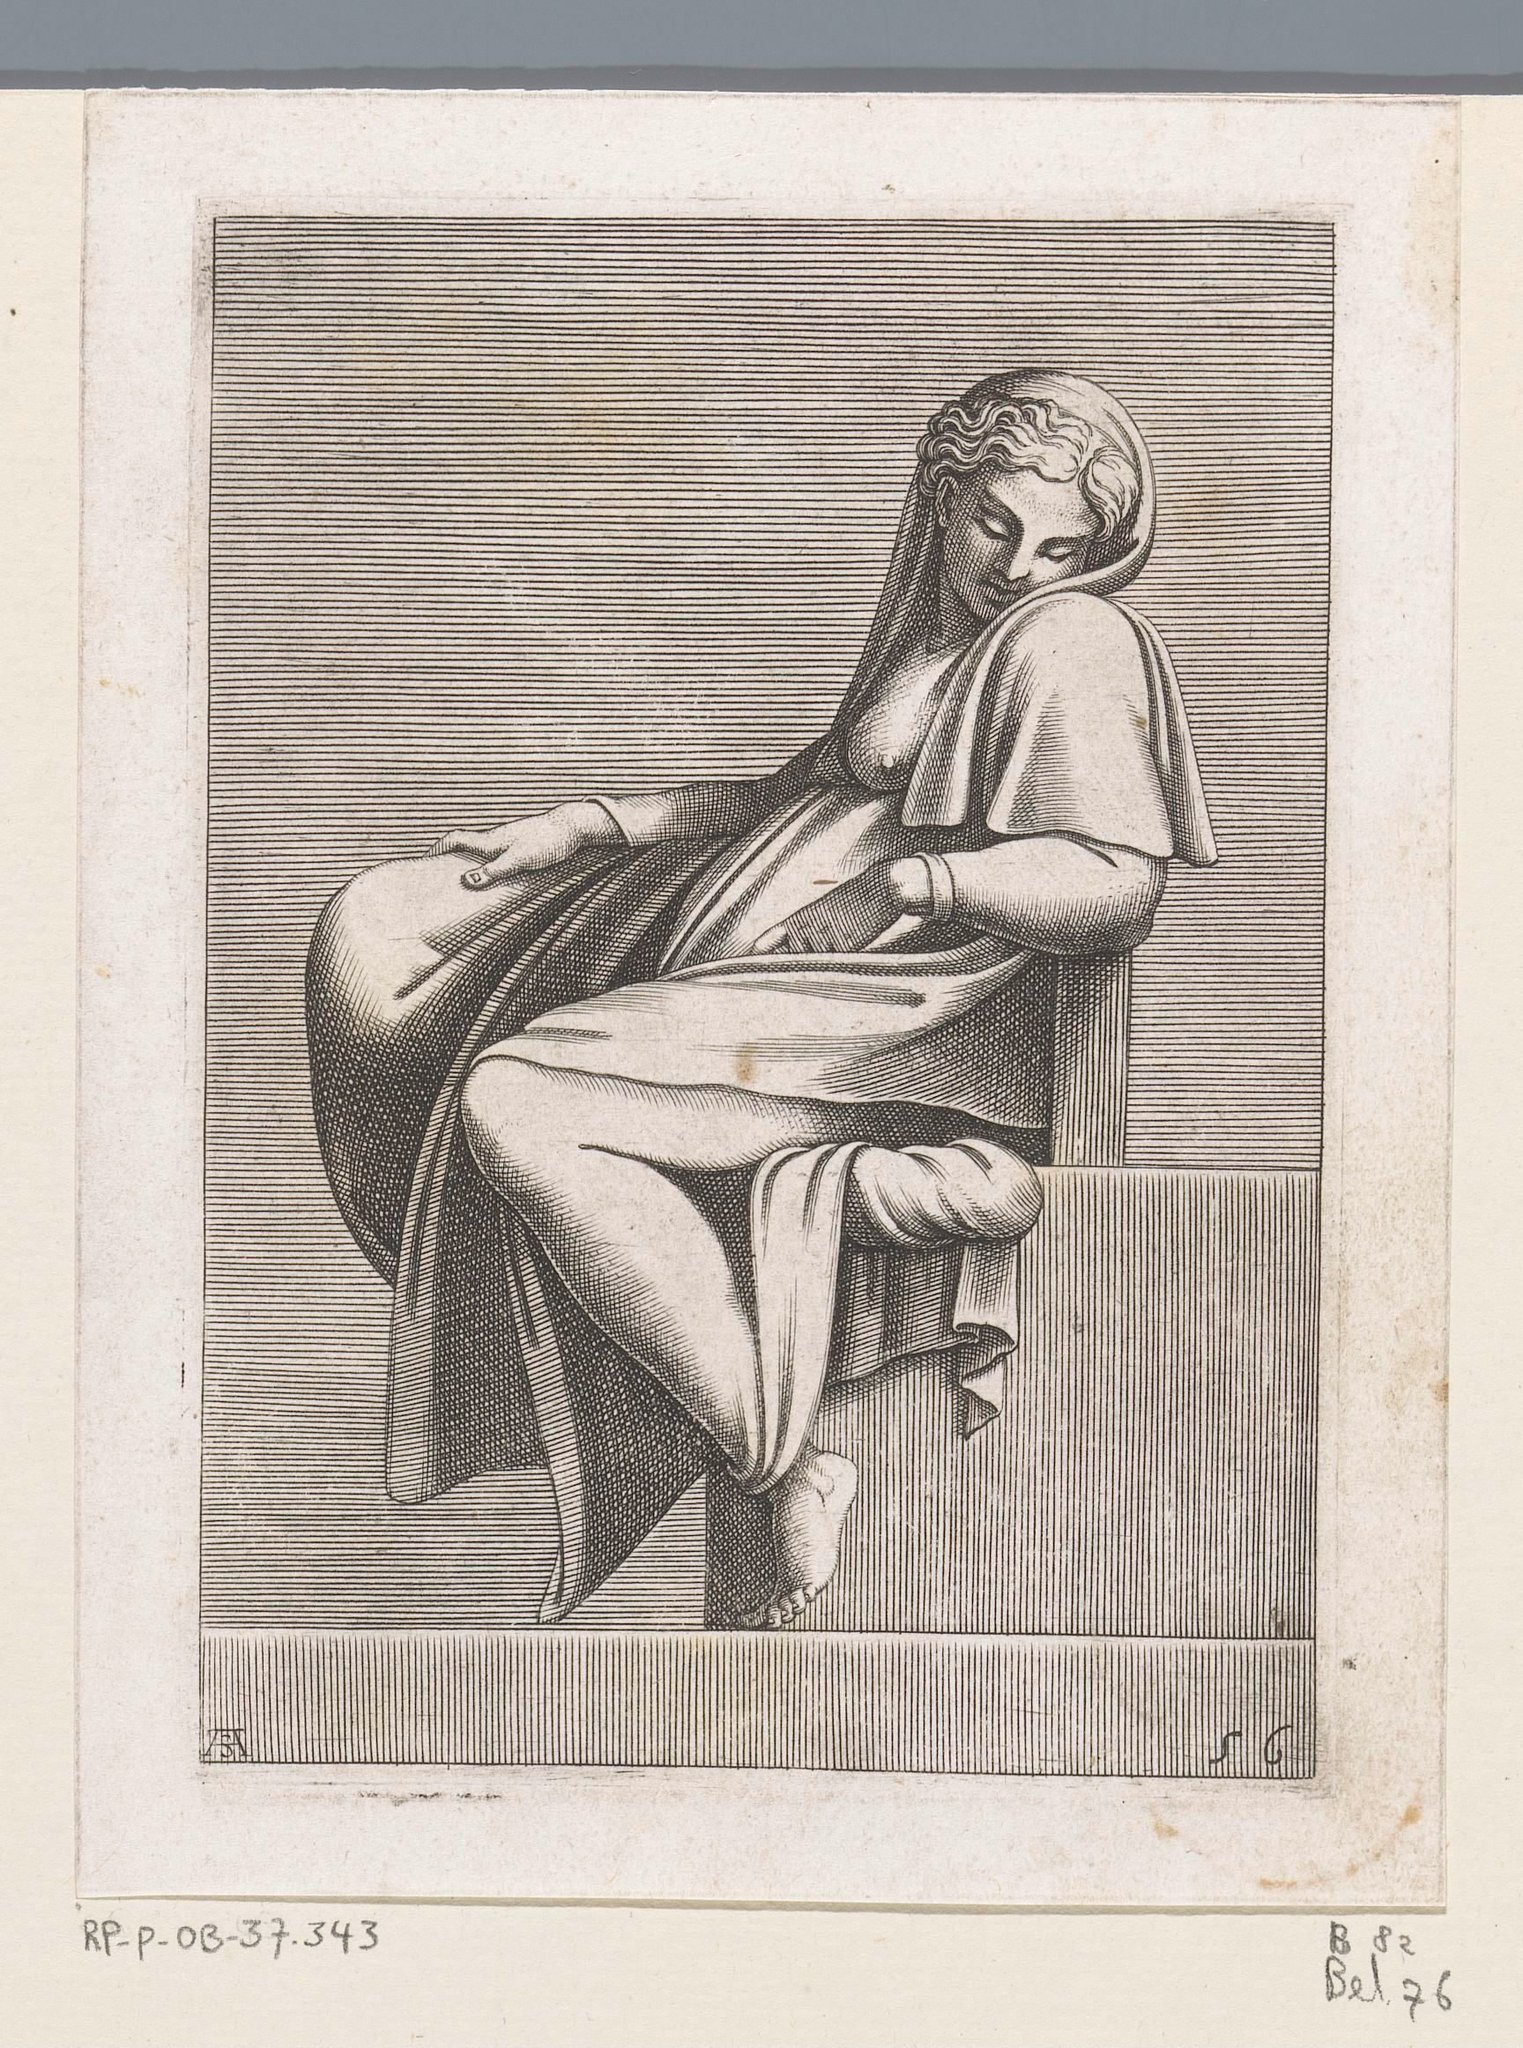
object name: print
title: Schilderingen in de Sixtijnse kapel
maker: adamo scultori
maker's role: painter, print maker, sculptor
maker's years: 1530-1585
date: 1585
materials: paper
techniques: engraving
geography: italy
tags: adolescent, young woman, maiden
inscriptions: collector's mark: Lugt 240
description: Deze prent maakt deel uit van een serie bestaande uit een titelprent en 72 prenten naar schilderingen door Michelangelo in de Sixtijnse Kapel in het Vaticaan.